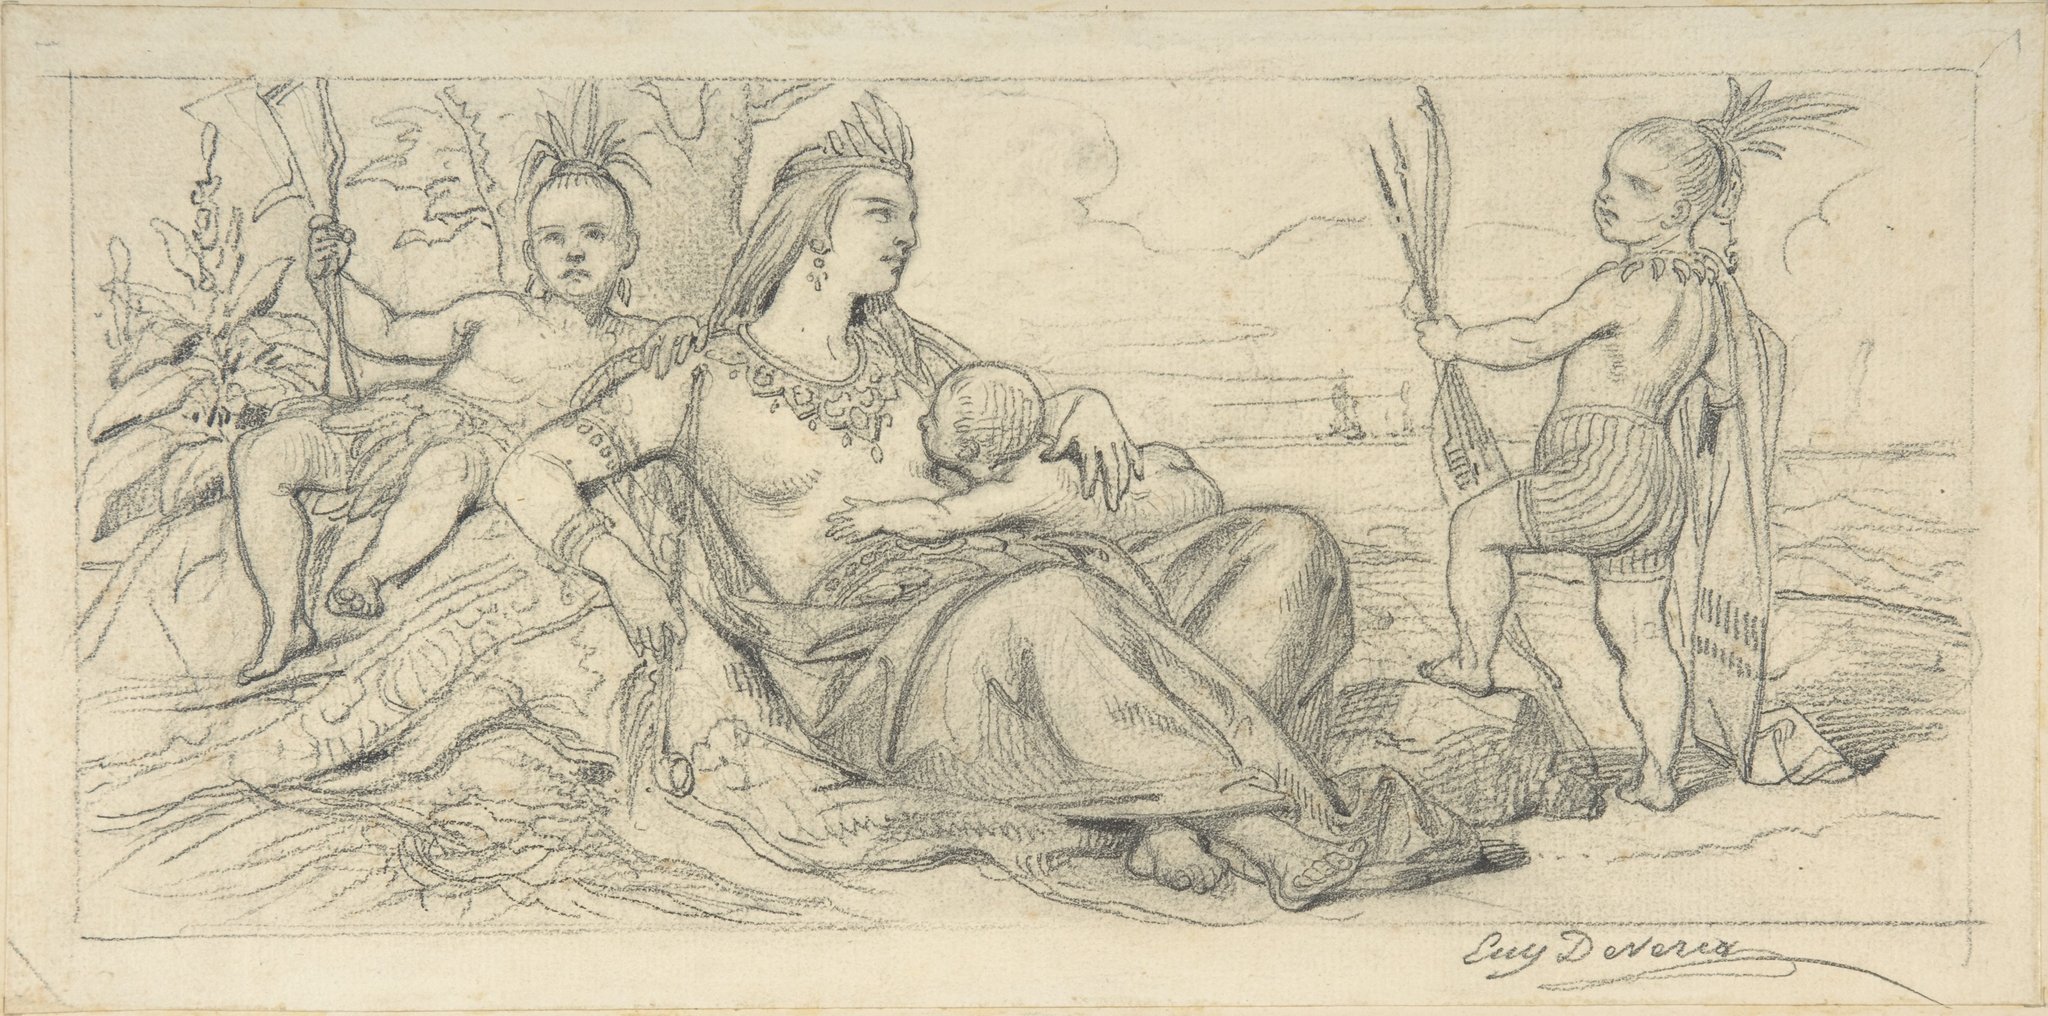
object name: drawing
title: Allegory of America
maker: eugène devéria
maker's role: draftsman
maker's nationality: french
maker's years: 1805-1865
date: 1834-1866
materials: graphite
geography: france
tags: boys,girls,infants,mothers